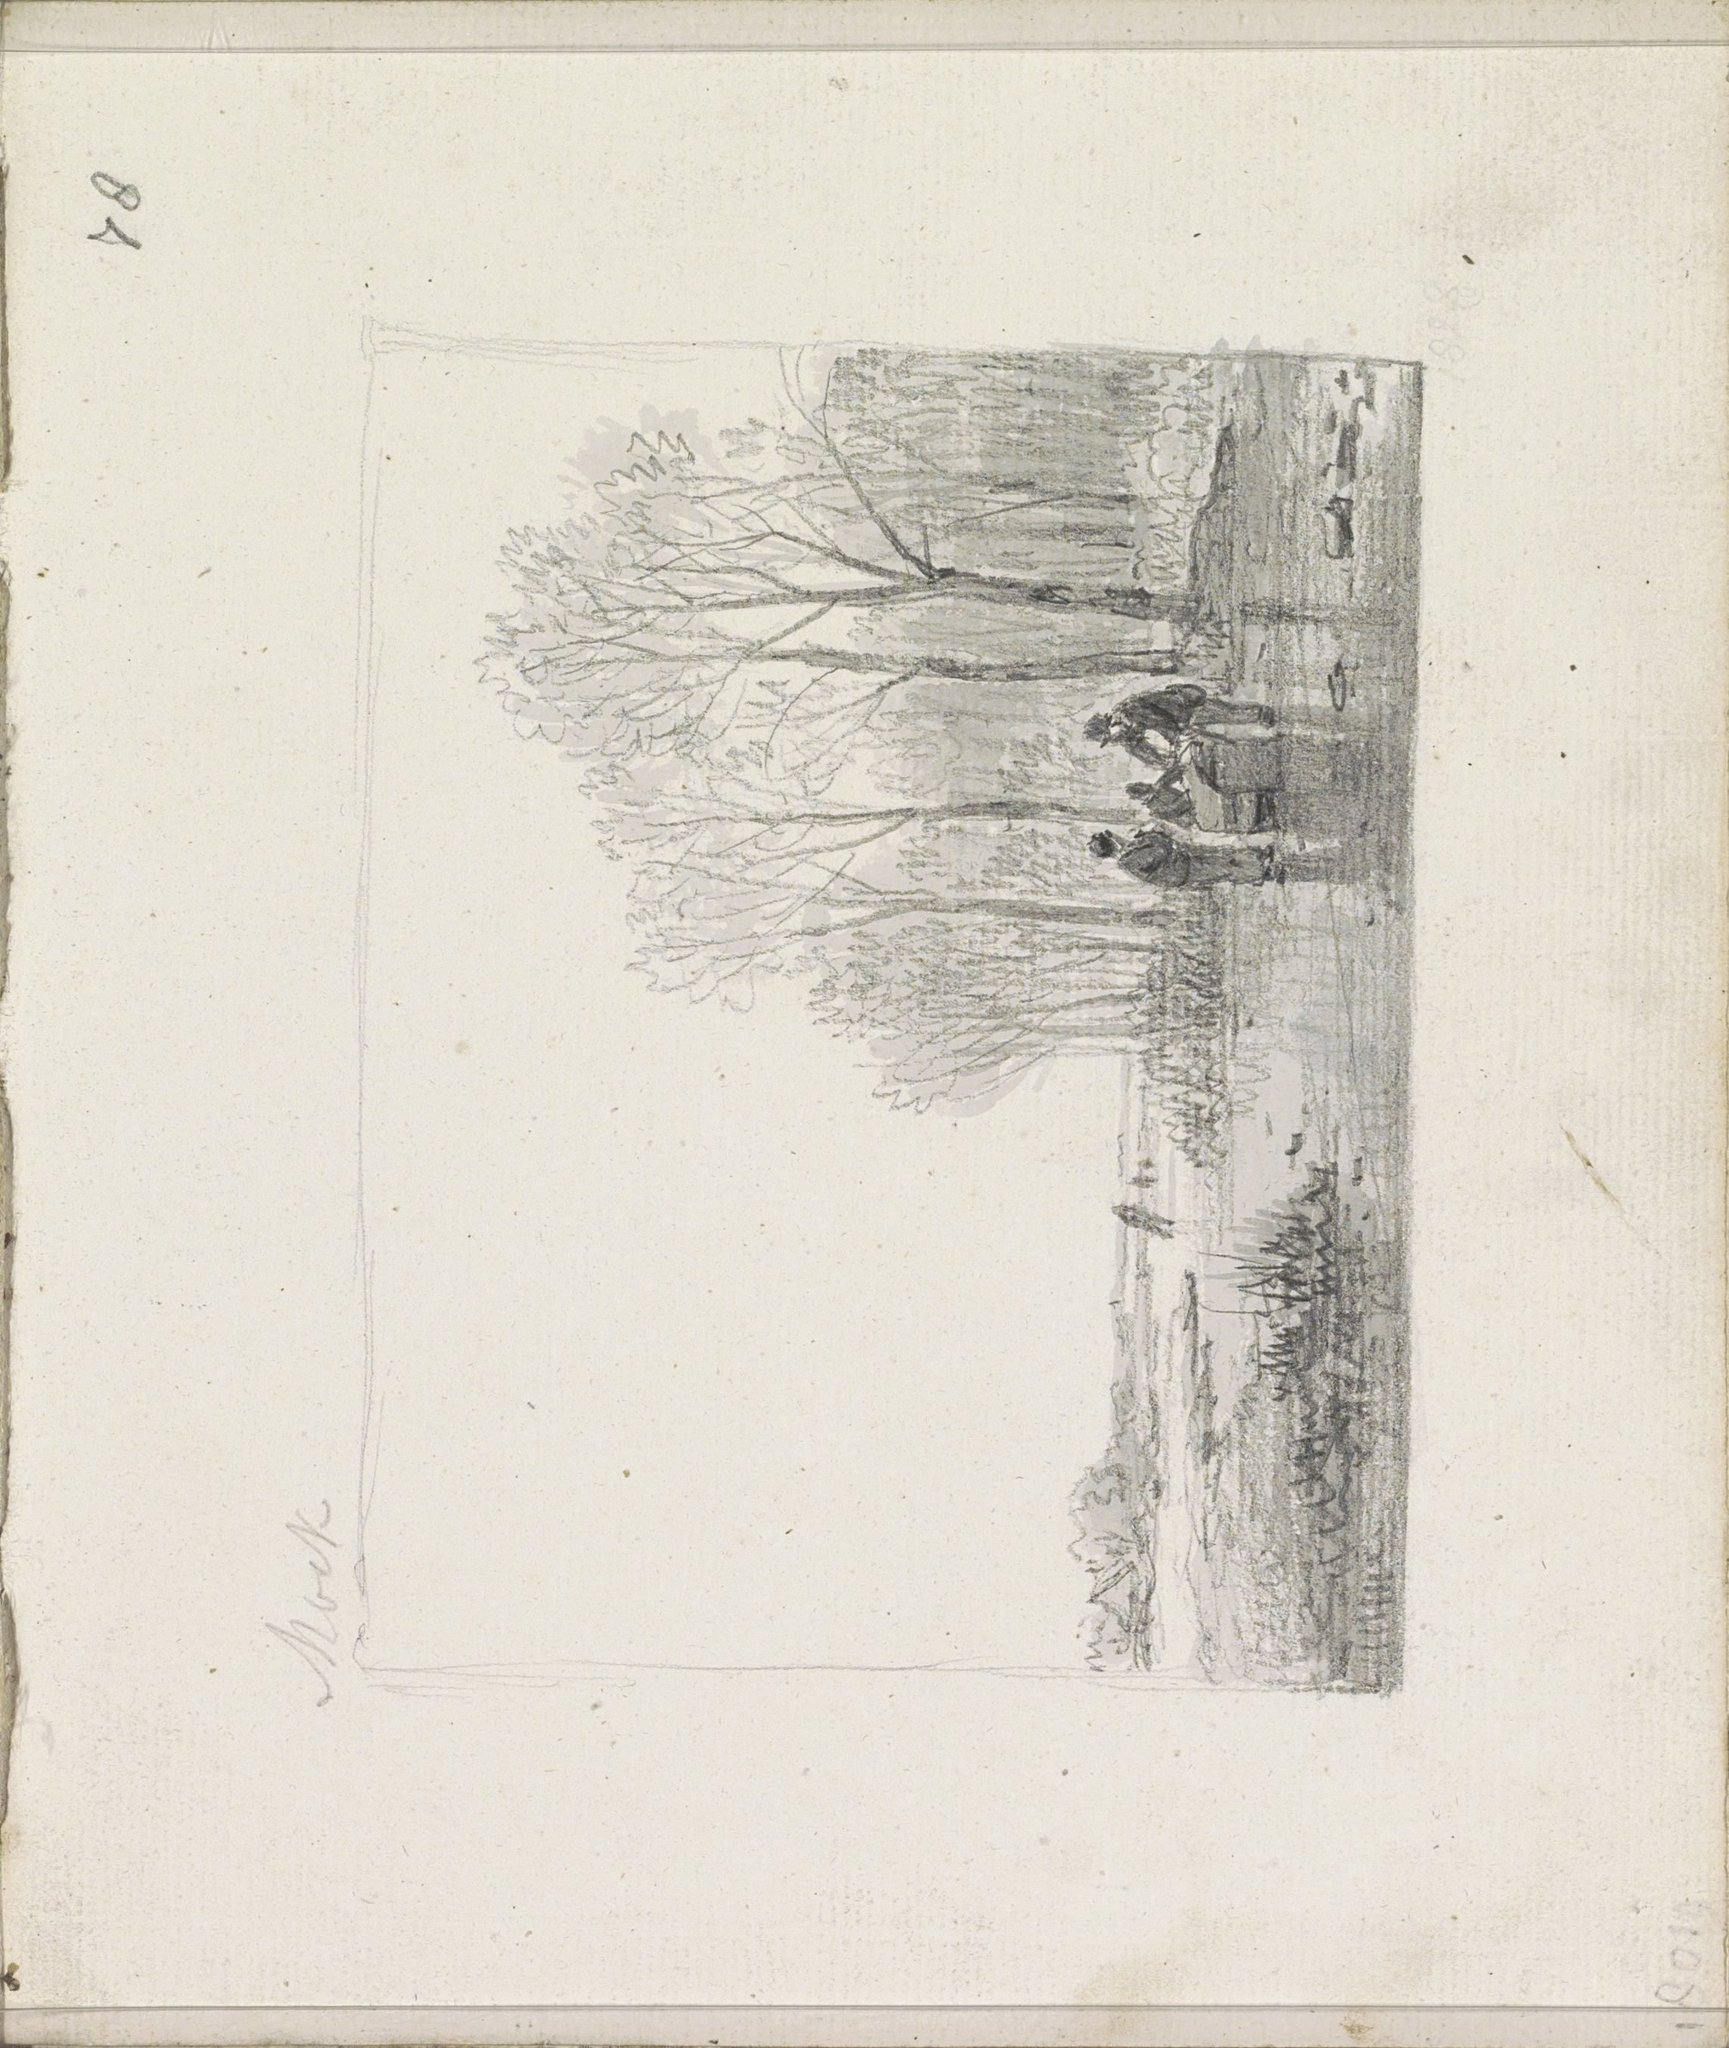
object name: sketchbook leaf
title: Figuren op een bevroren vaart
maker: andreas schelfhout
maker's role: draughtsman, painter, print maker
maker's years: 1787-1870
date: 1828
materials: paper, pencil, watercolor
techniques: brush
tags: frost, freezing weather, landscapes with waters, waterscapes, seascapes (in the temperate zone) (+ landscape with figures, staffage)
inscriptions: date and inscription: ‘M?oek/ 1828’, number: ‘78/ 18019’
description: Blad 92 recto uit een schetsboek met 95 bladen.